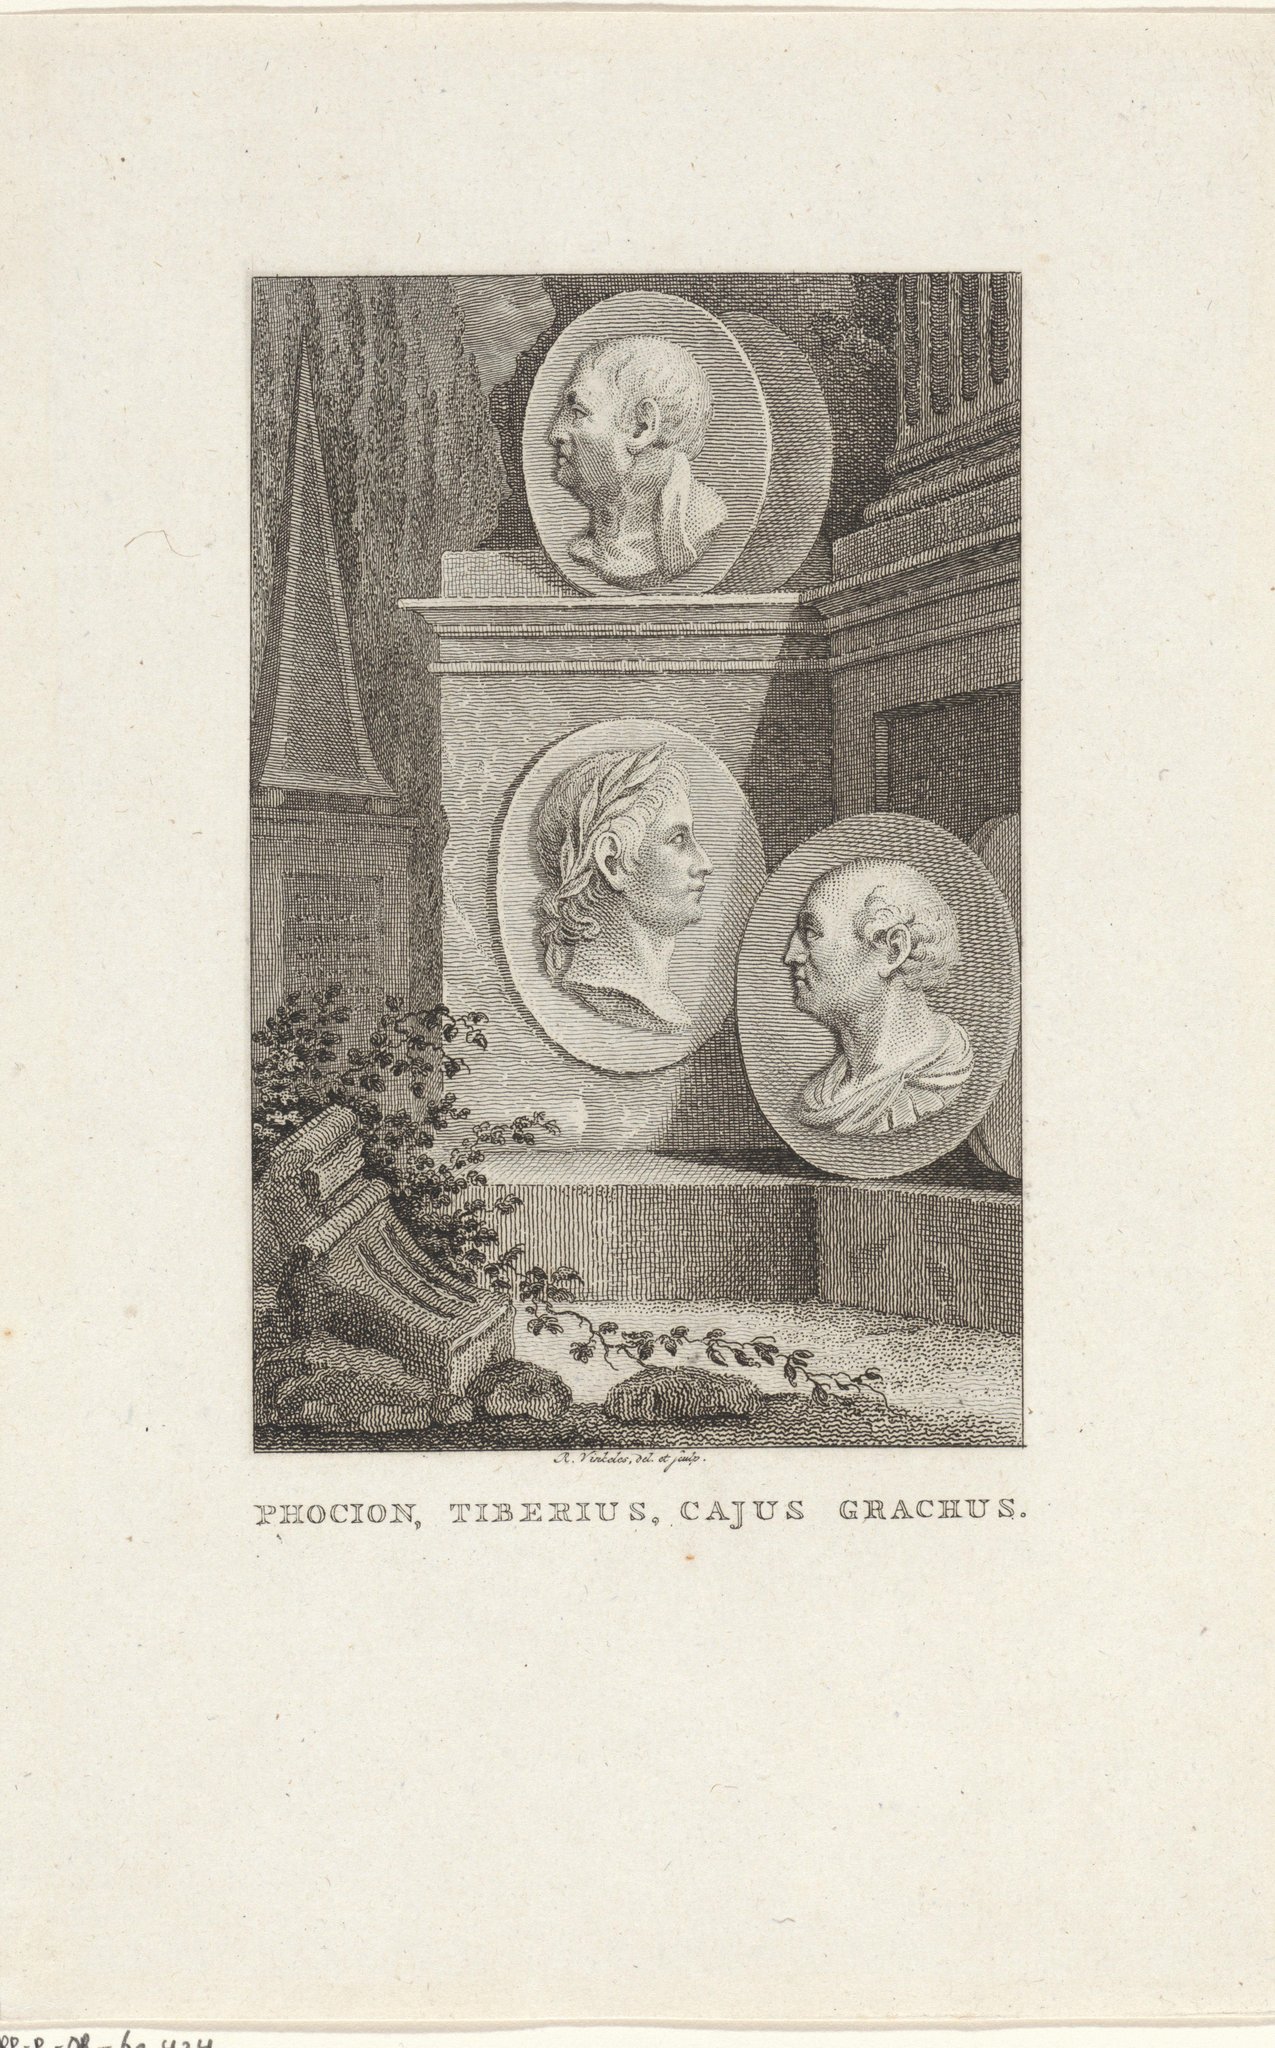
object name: print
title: Medaillons met portretten van Phocion, Tiberius en Gaius Sempronius Gracchus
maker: reinier vinkeles (i)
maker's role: draughtsman, print maker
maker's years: 1741-1816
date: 1789-1809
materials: paper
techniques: etching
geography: amsterdam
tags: (story of) gaius sempronius gracchus, base (~ column, pillar), (story of) phocion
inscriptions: collector's mark: Lugt 240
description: Prent ook gebruikt als boekillustratie in: Plutarchus [bewerkt door E. Wassenbergh en H. Bosscha]. De levens van doorluchtige Grieken en Romeinen, onderling vergeleeken (...). 12 dln. Amsterdam: Johannes Allart, 1789-1809.